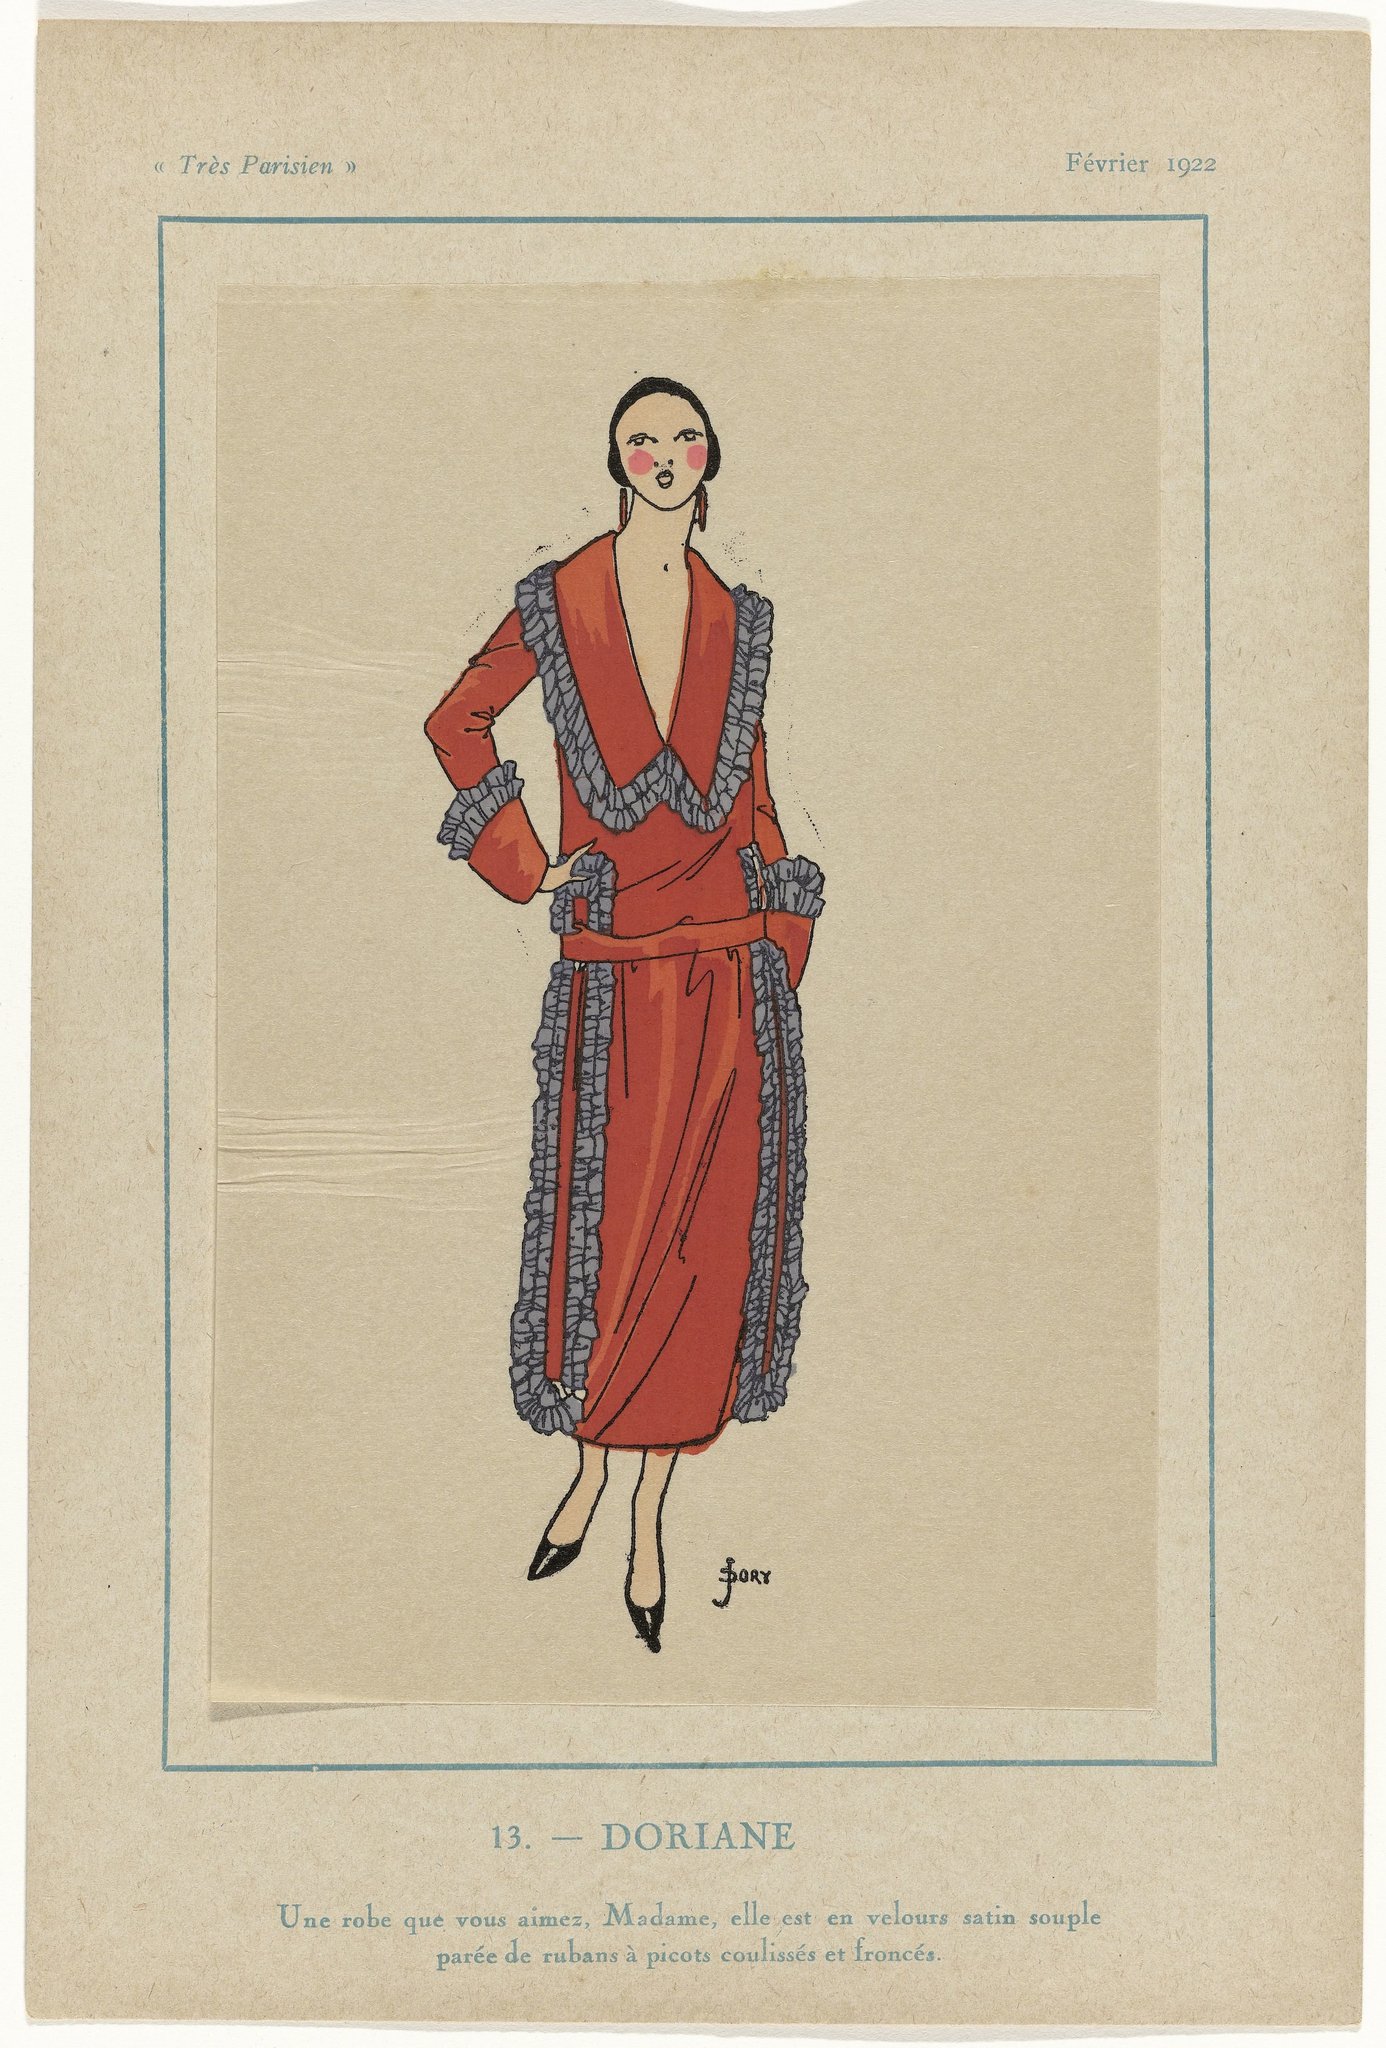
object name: fashion print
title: Très Parisien, février 1922: 13.- DORIANE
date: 1922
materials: paper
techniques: hand coloring, letterpress printing, lithography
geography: paris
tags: border, ribbon, braid (+ women's clothes), fashion plates, dress, gown (+ women's clothes)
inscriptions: caption: ‘13. - DORIANE / Une robe que vous aimez, Madame, elle est en velours satin souple parée de rubans à picots coulissés et froncés.’, title: ‘Très Parisien / Février 1922’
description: Japon van rood fluweel, versierd met muisgrijze gerimpelde banden. Prent uit het modetijdschrift Très Parisien (1920-1936).